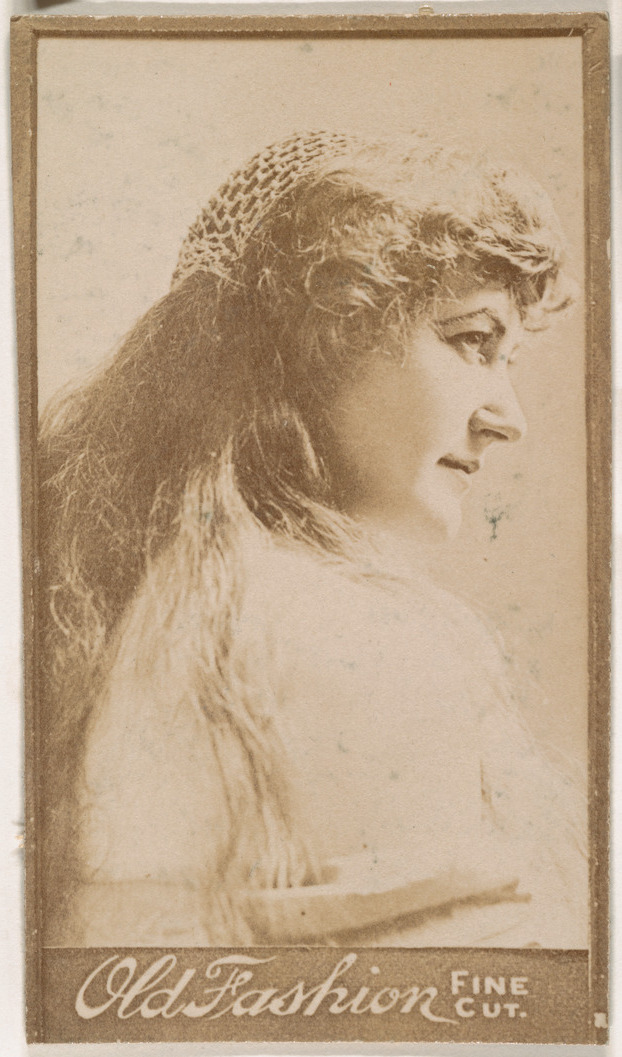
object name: photograph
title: Actress in profile, from the Actresses series (N664) promoting Old Fashion Fine Cut Tobacco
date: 1888-1890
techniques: albumen silver print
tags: portraits,women,actresses